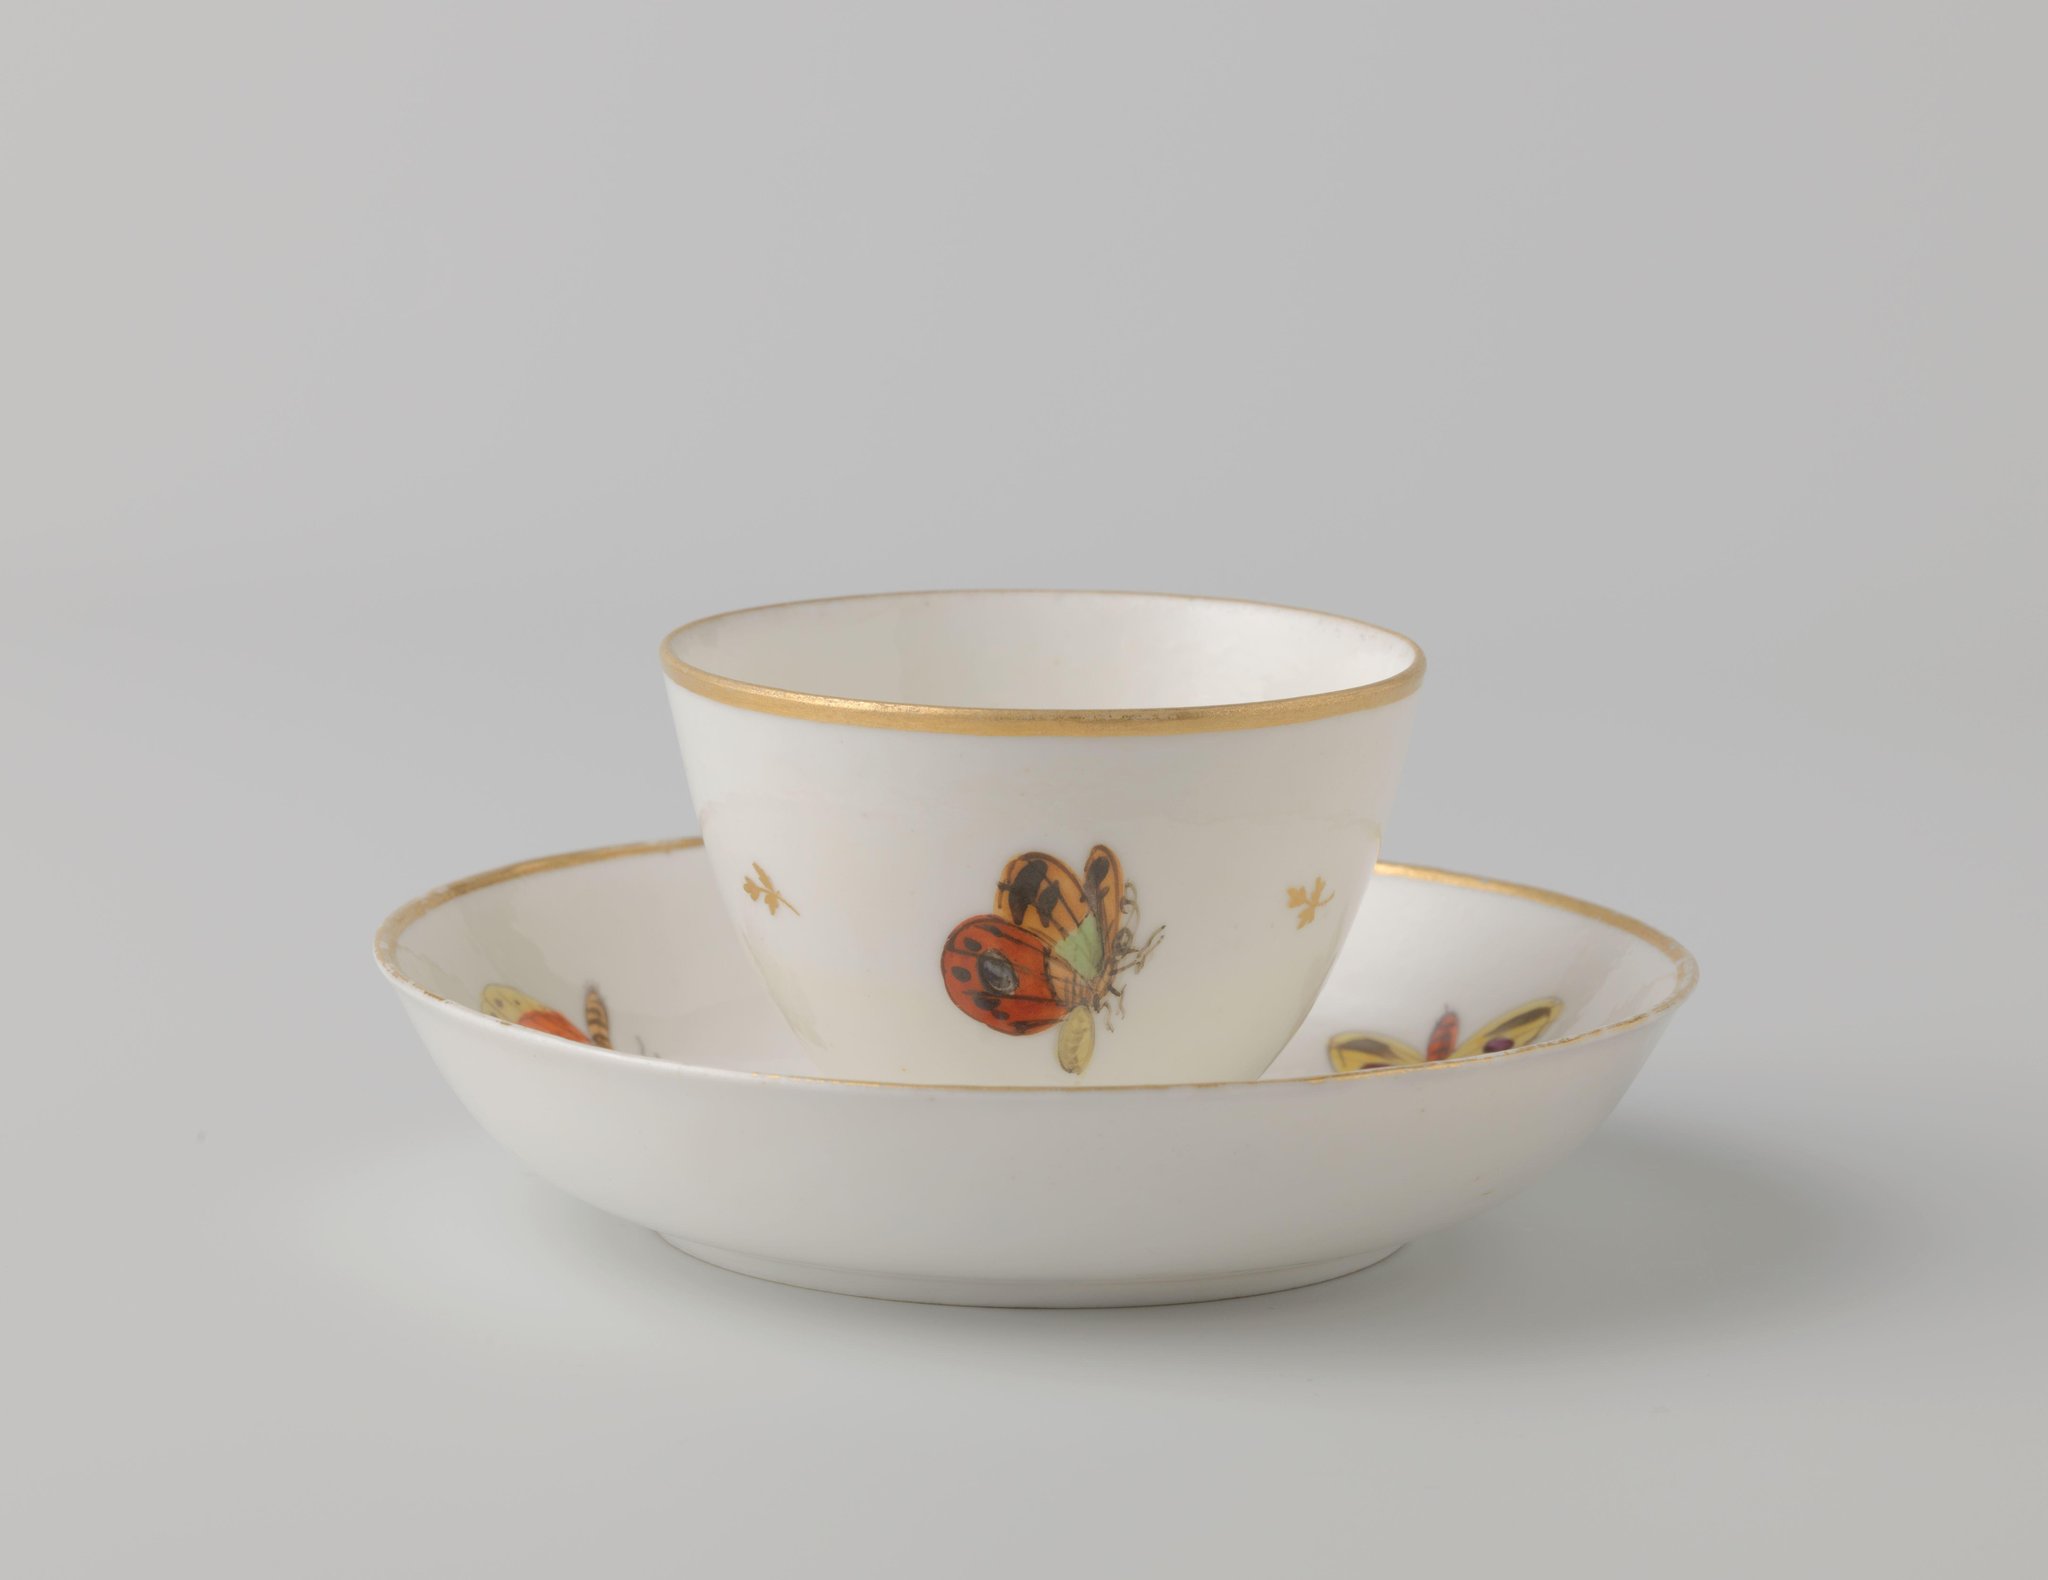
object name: cup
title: Kop beschilderd met vlinders en libellen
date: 1784-1809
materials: porcelain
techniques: painted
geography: ouder-amstel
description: Kop zonder oor veelkleurig beschilderd met vlinders en libellen. Gemerkt: Amstel.